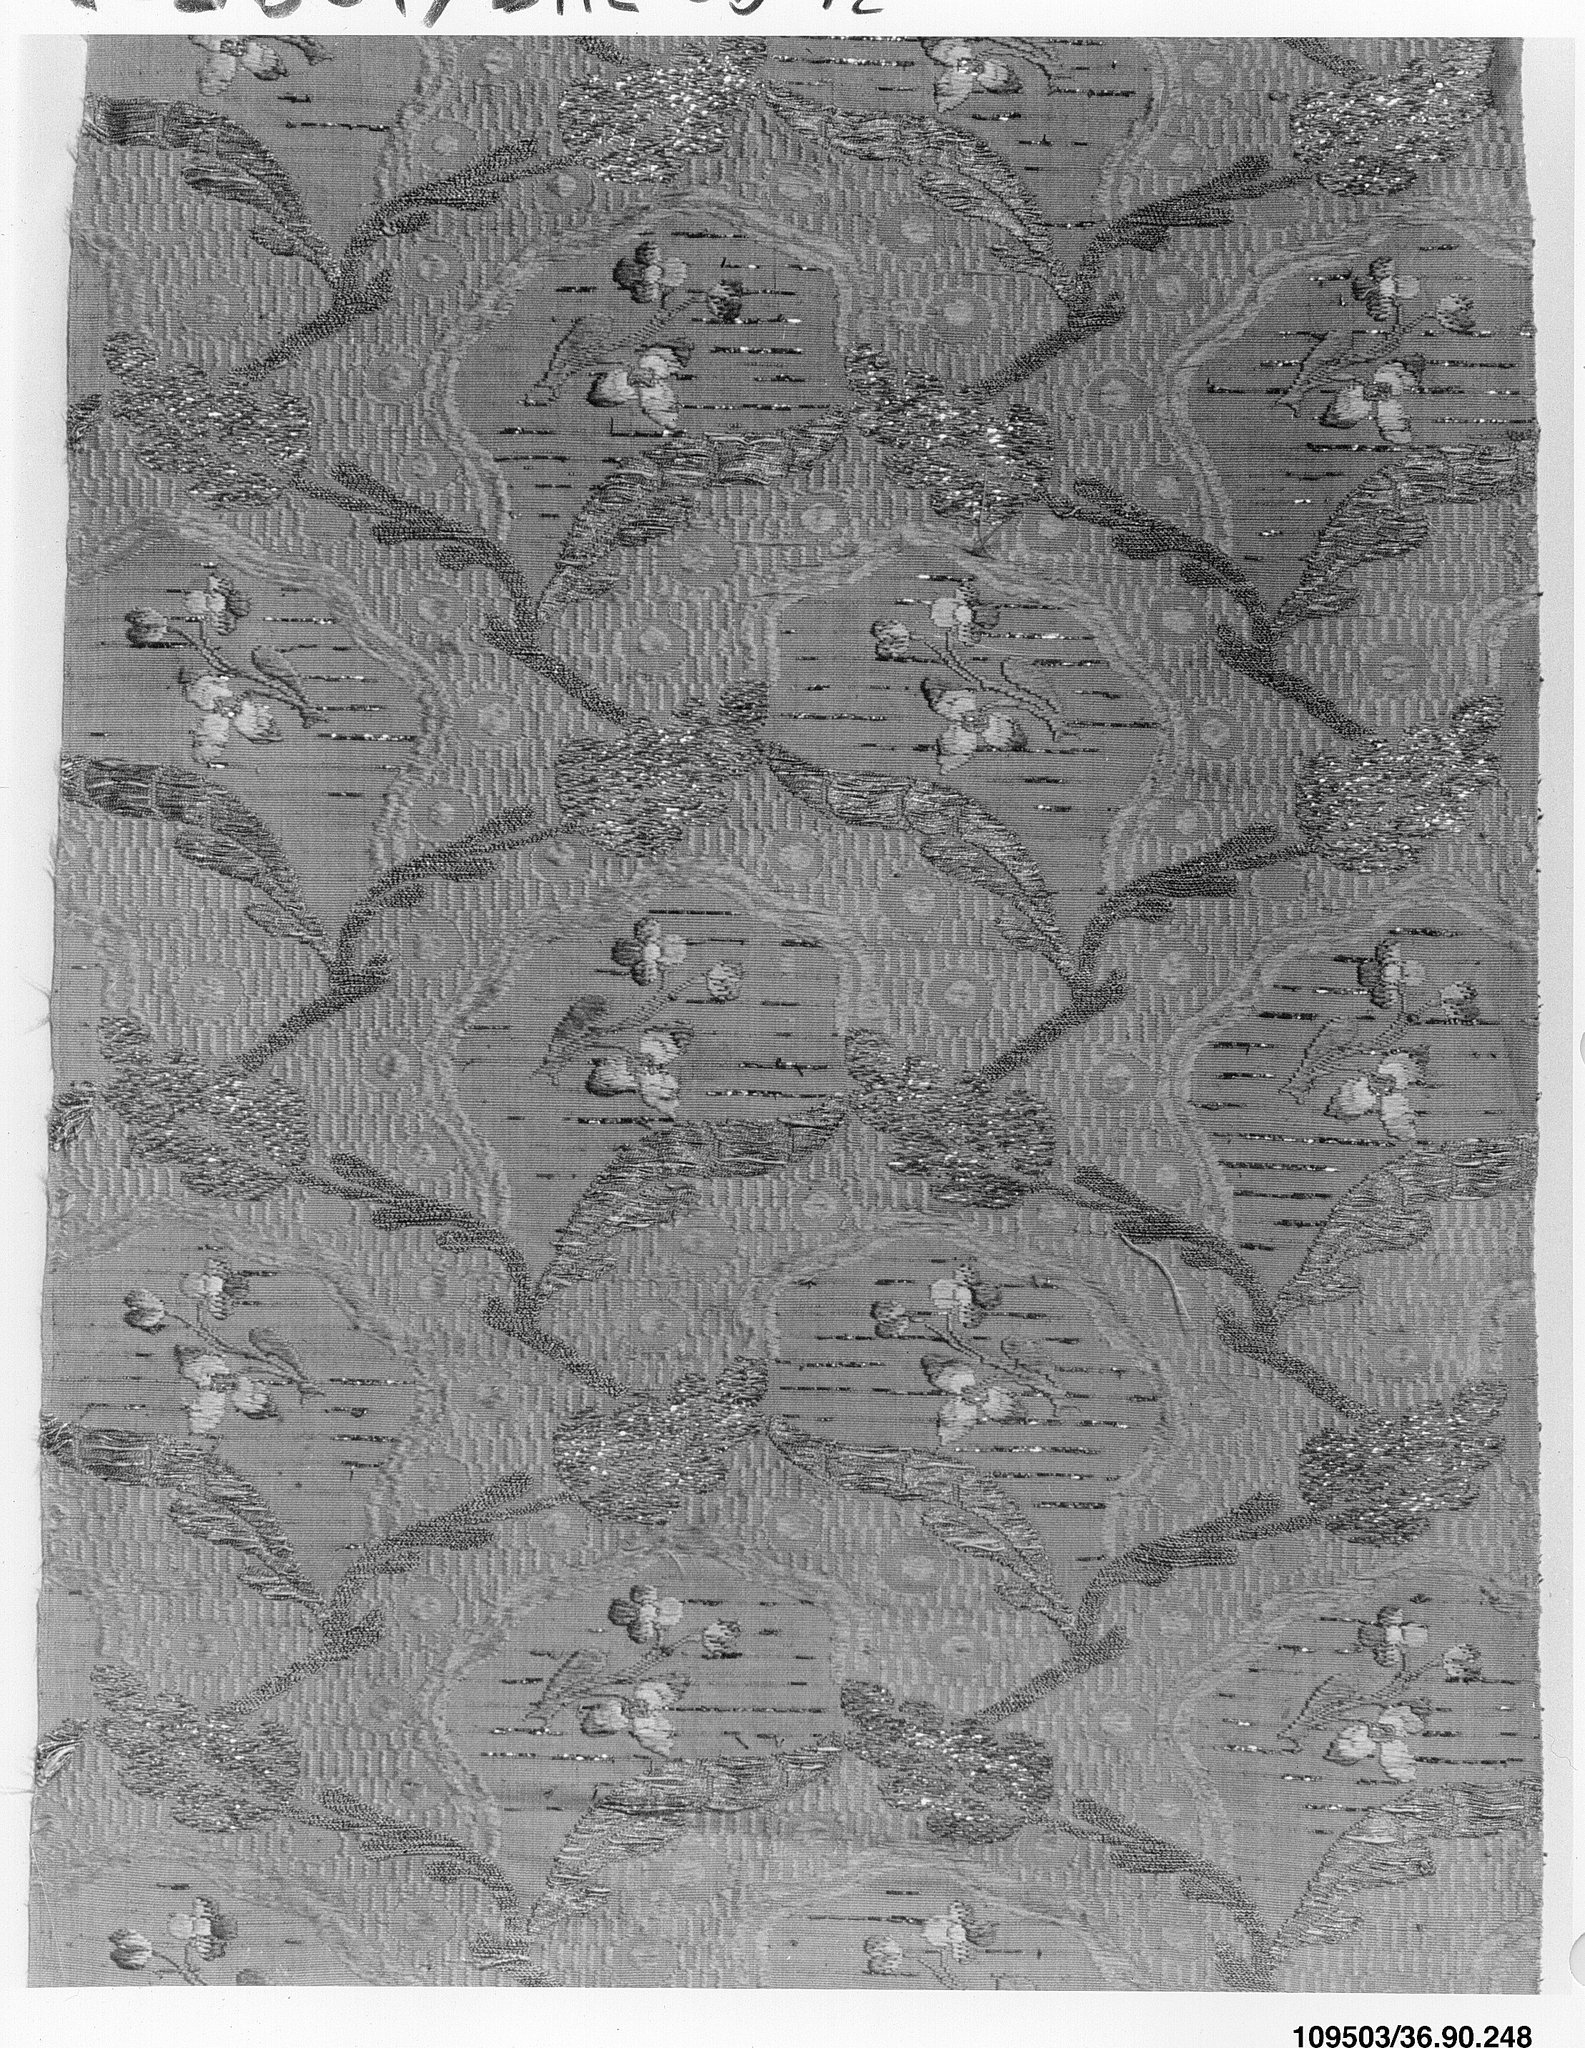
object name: piece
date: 1750-1775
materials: metal thread, silk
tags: flowers